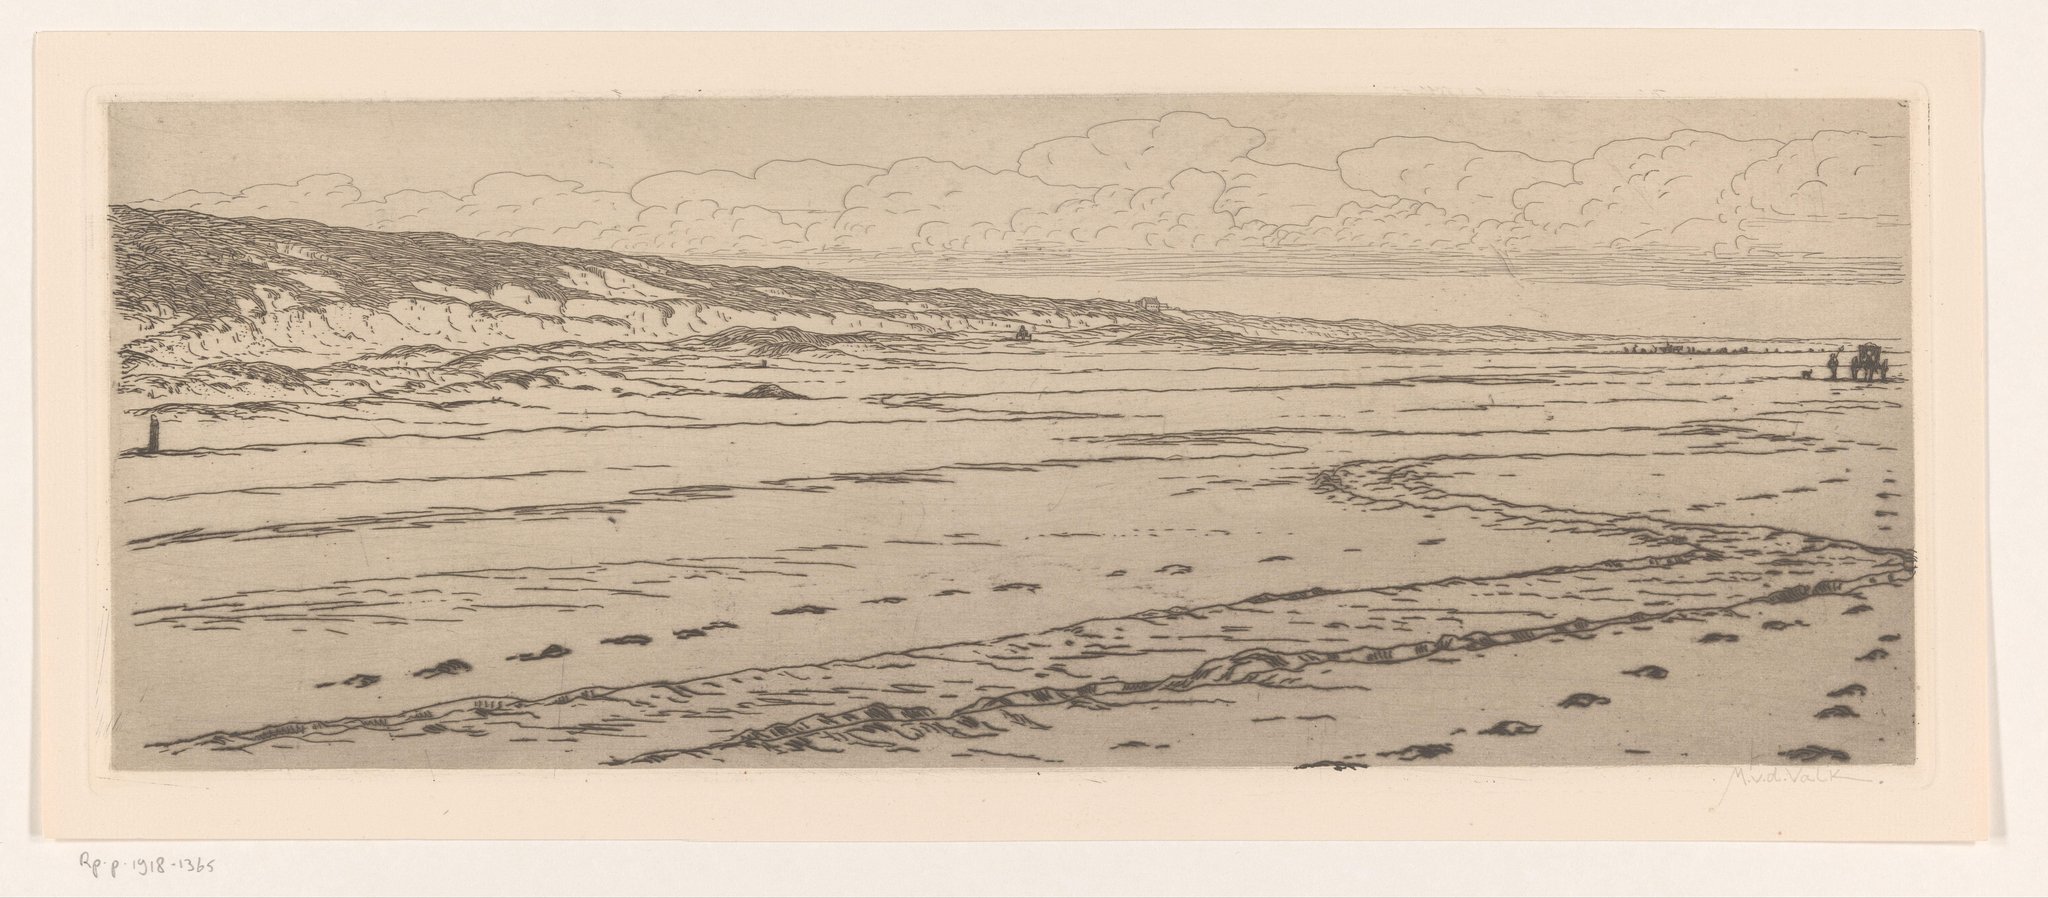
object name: print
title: Strand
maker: maurits van der valk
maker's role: draughtsman, print maker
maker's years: 1857-1935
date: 1867-1918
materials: paper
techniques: etching, intaglio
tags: dune coast, beach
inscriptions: collector's mark: Lugt 2233